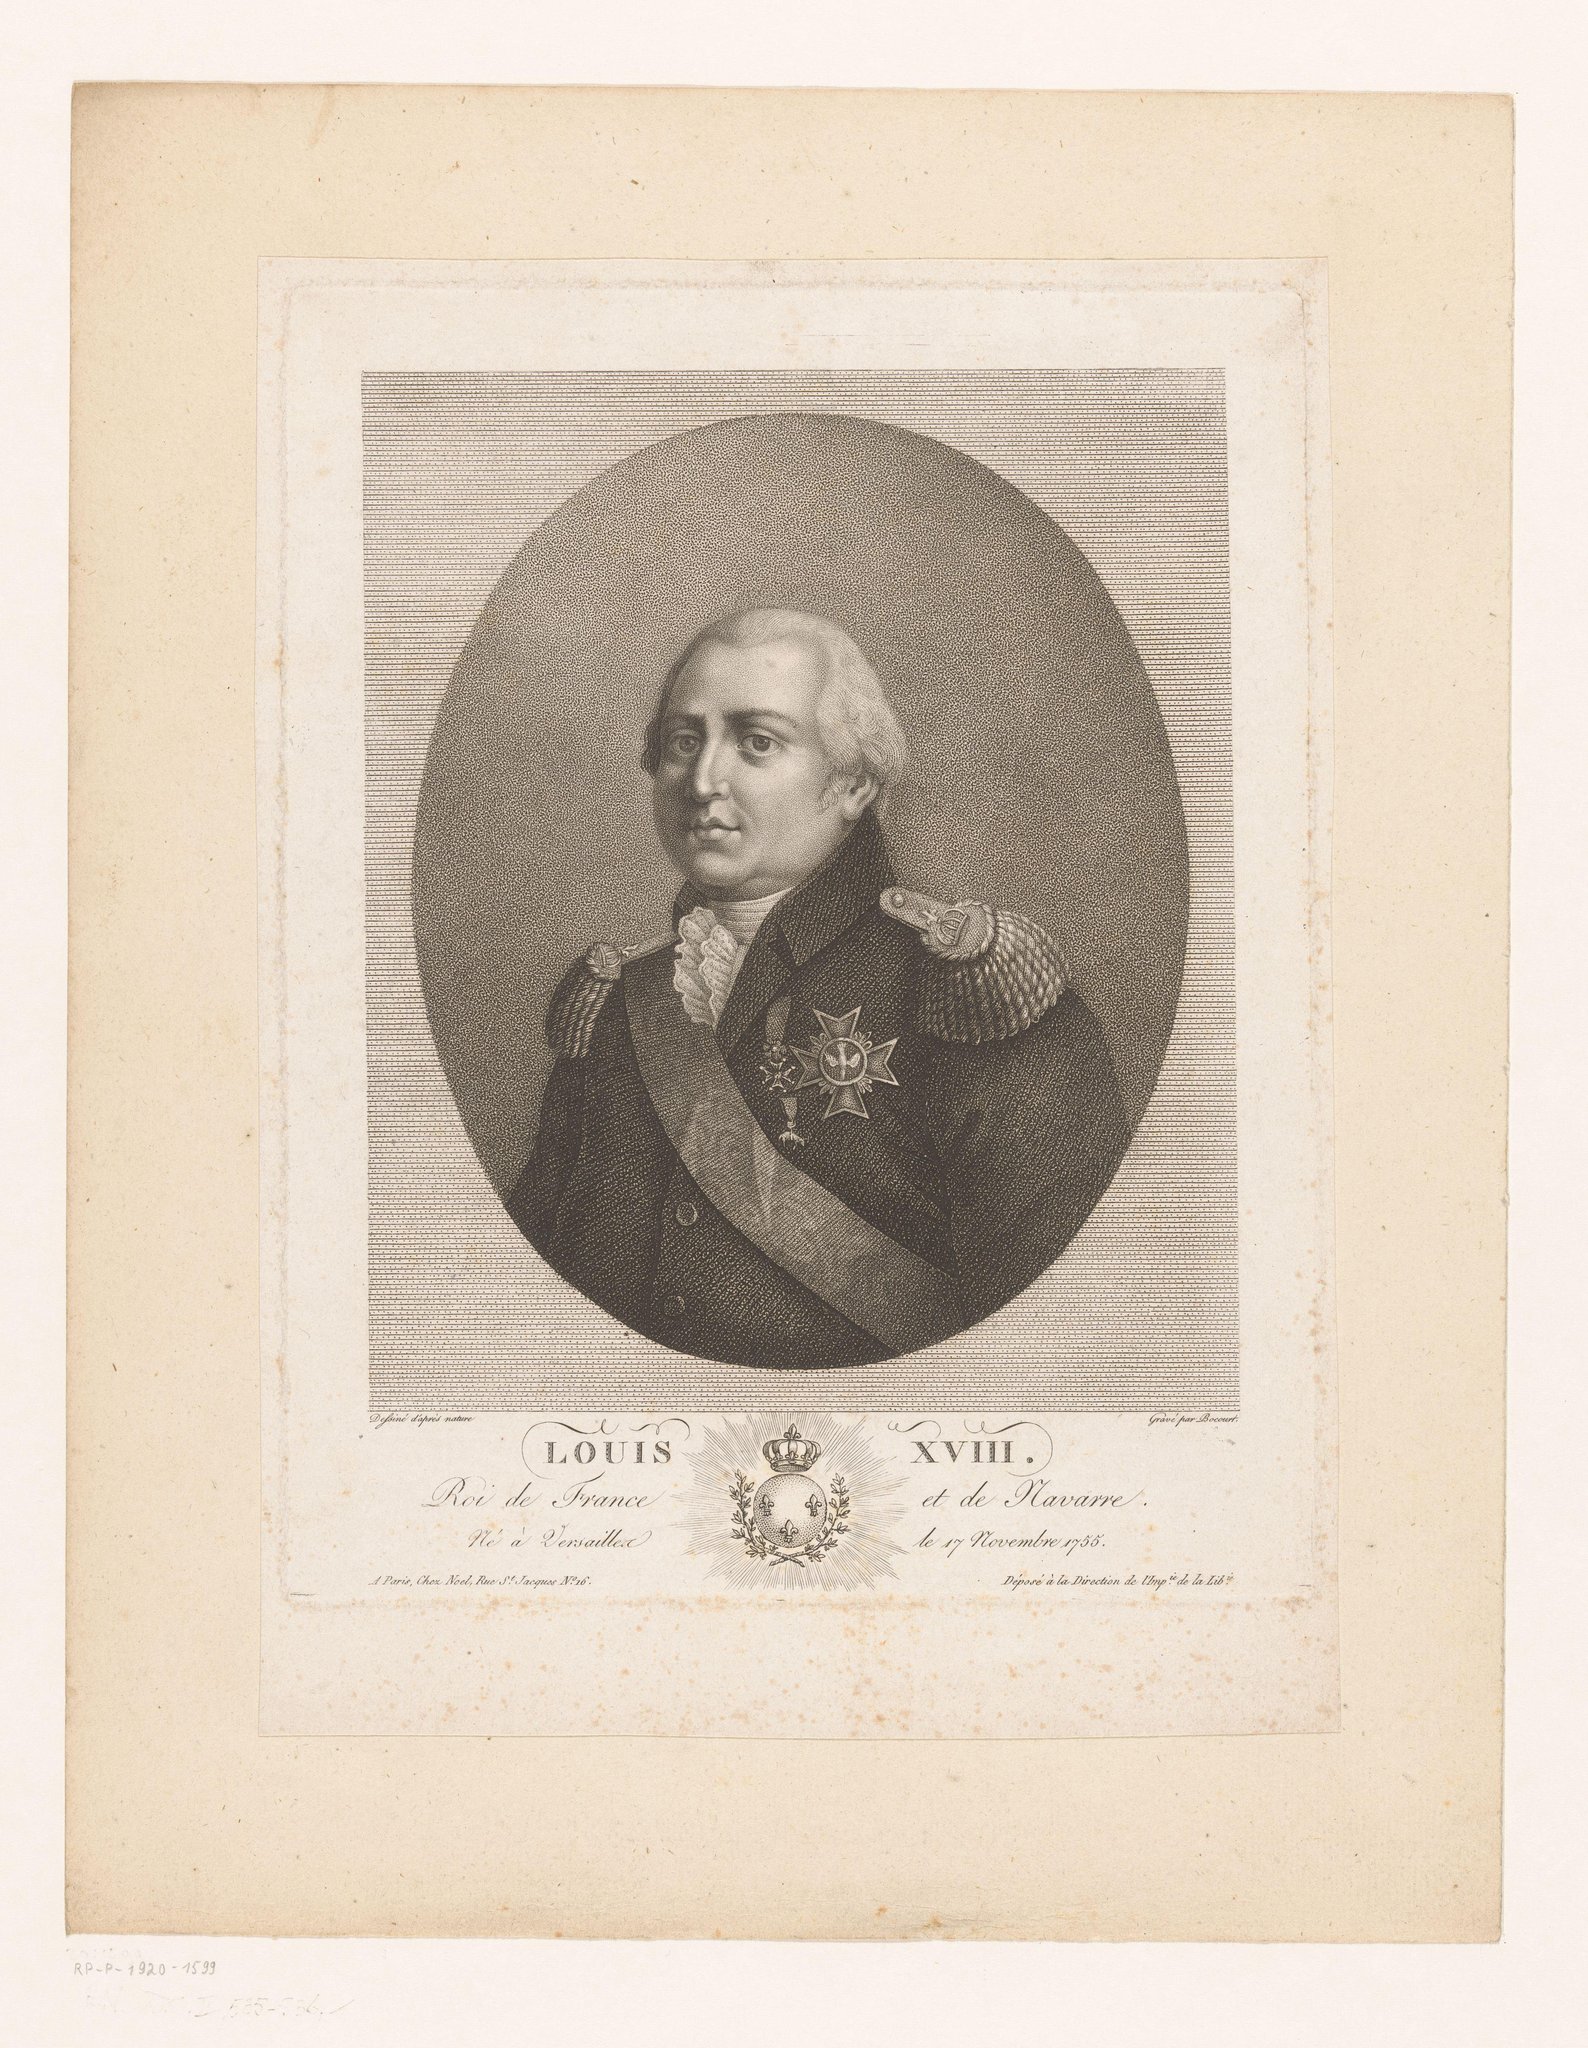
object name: print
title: Portret van Lodewijk XVIII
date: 1793-1846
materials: paper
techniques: etching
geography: paris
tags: paris, lodewijk xviii (koning van frankrijk), ornament ~ medallion, historical persons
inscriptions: collector's mark: Lugt 2228